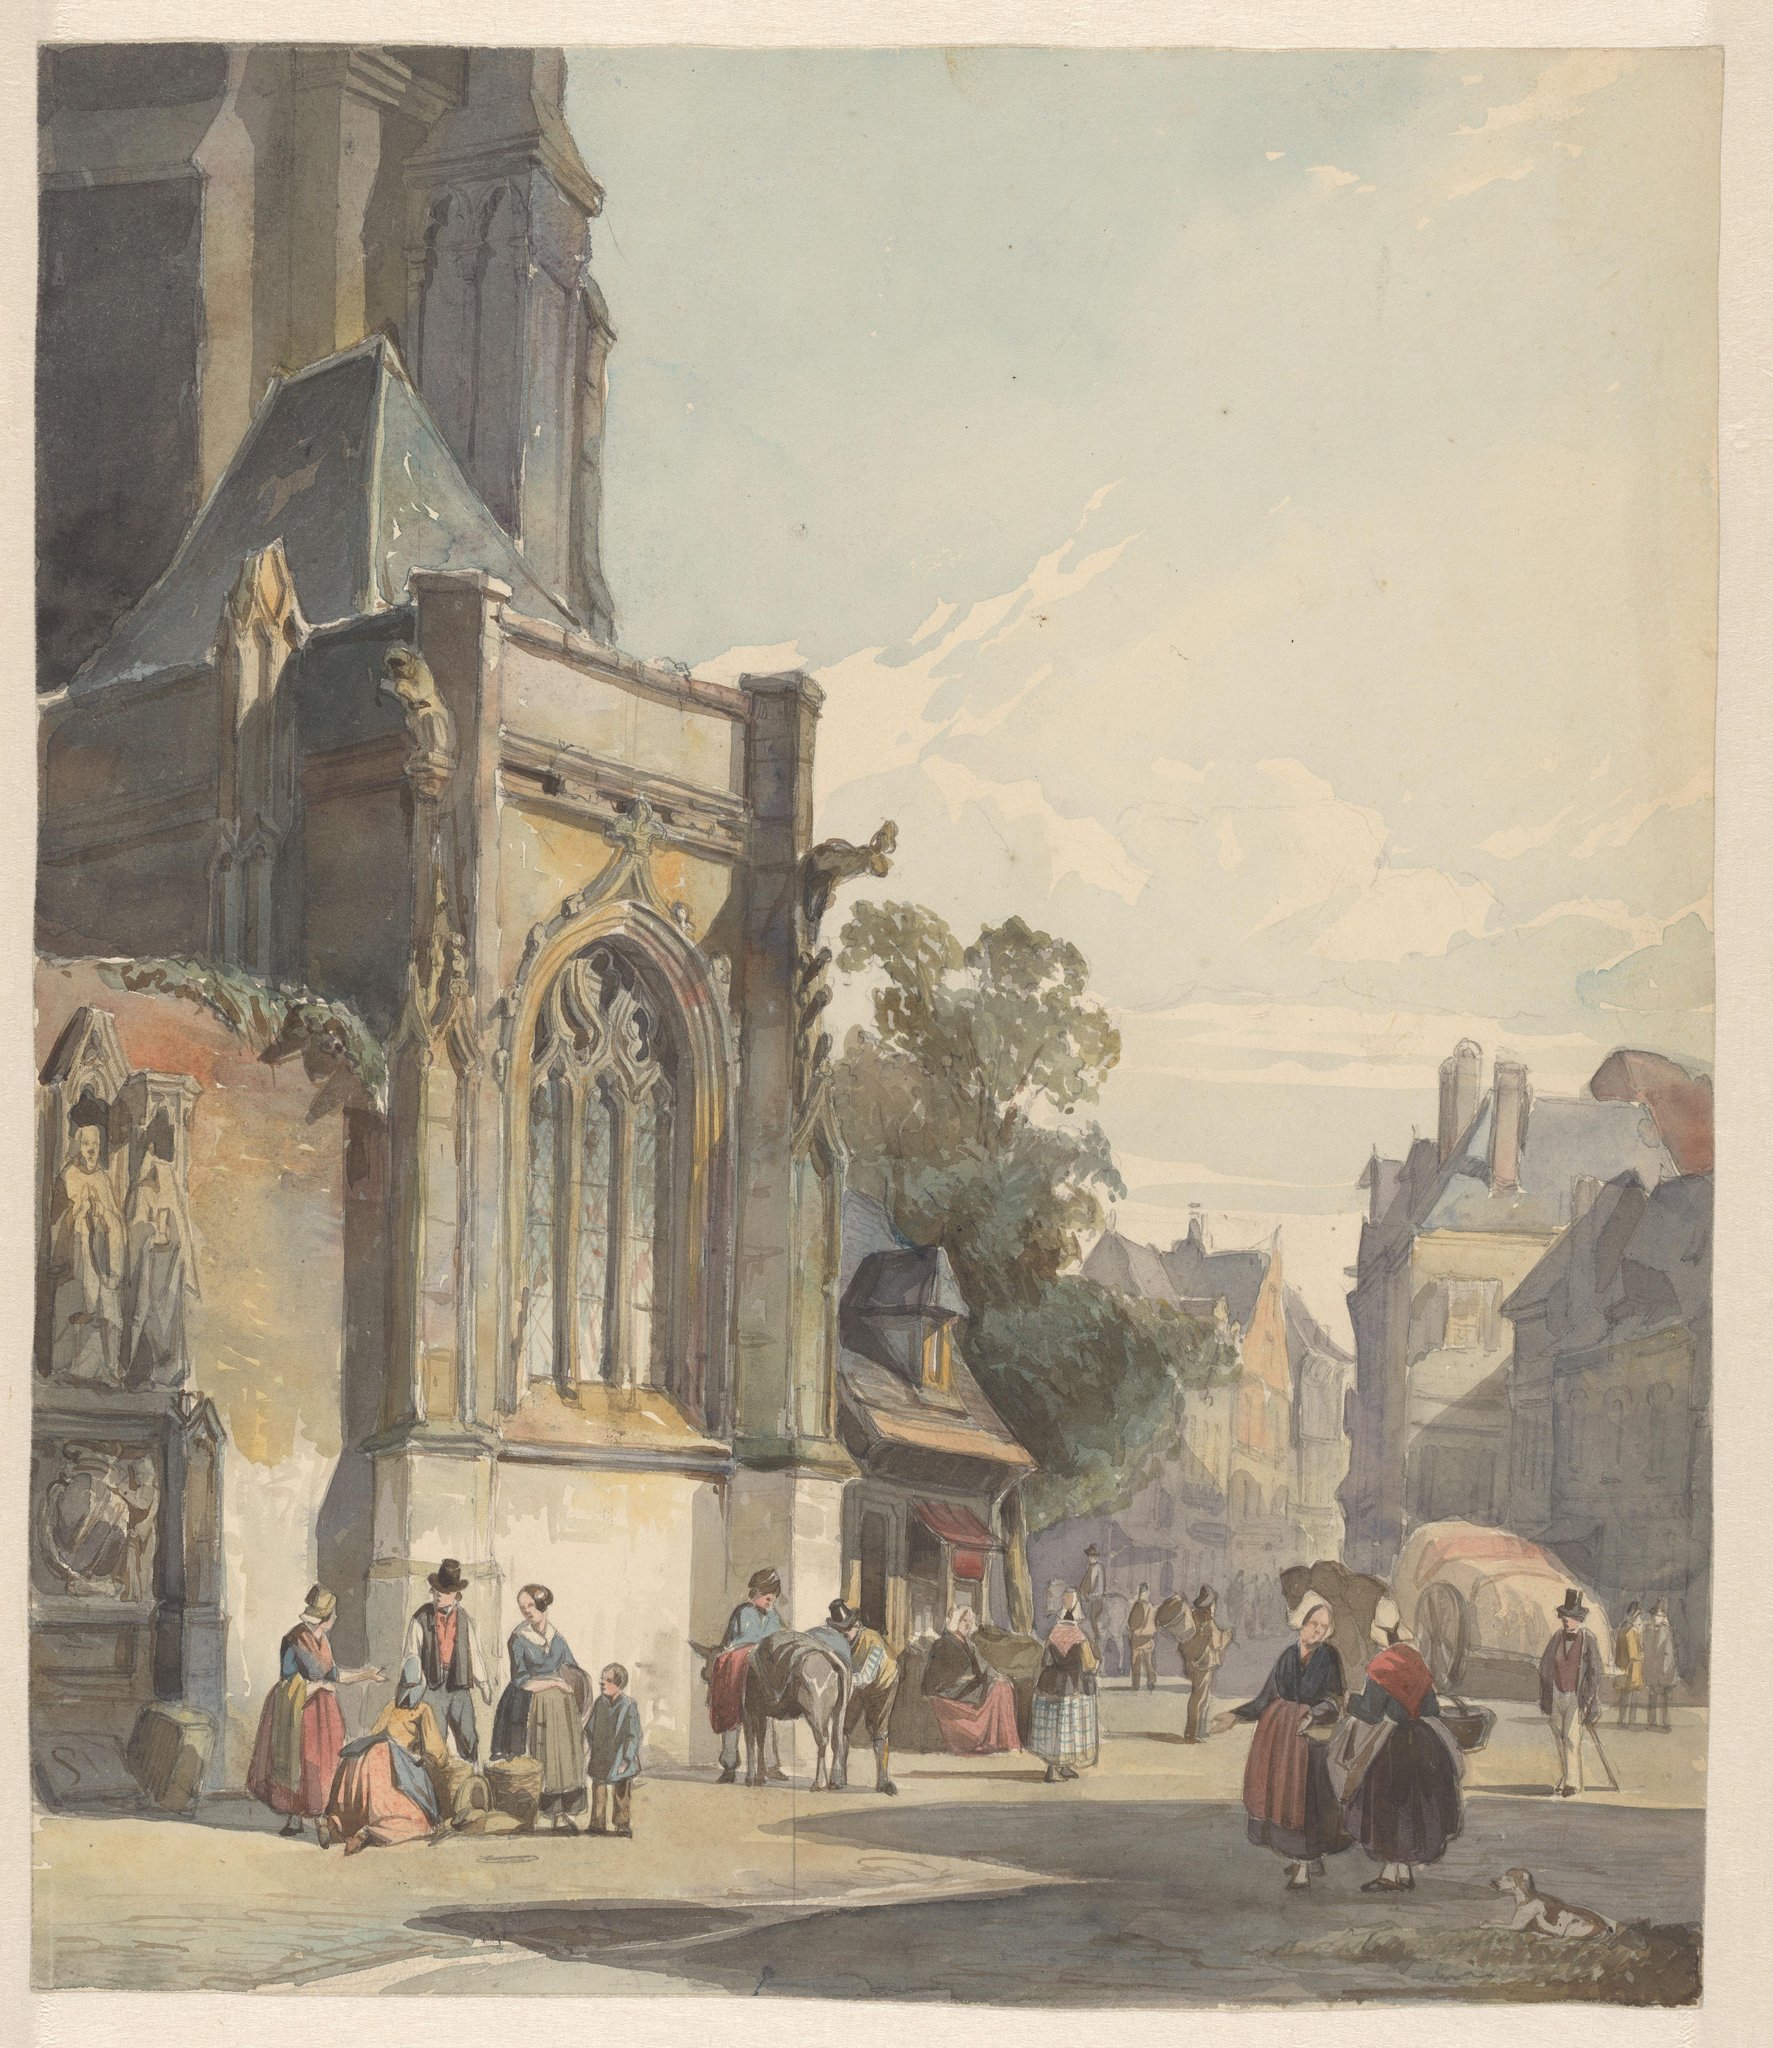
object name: drawing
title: Stadsgezicht met kerkgebouw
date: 1840-1860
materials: paper, pencil, watercolor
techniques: brush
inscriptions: annotation: ‘Juiste Grootte in den dag der Lijst / Doek’, number: ‘00:507’